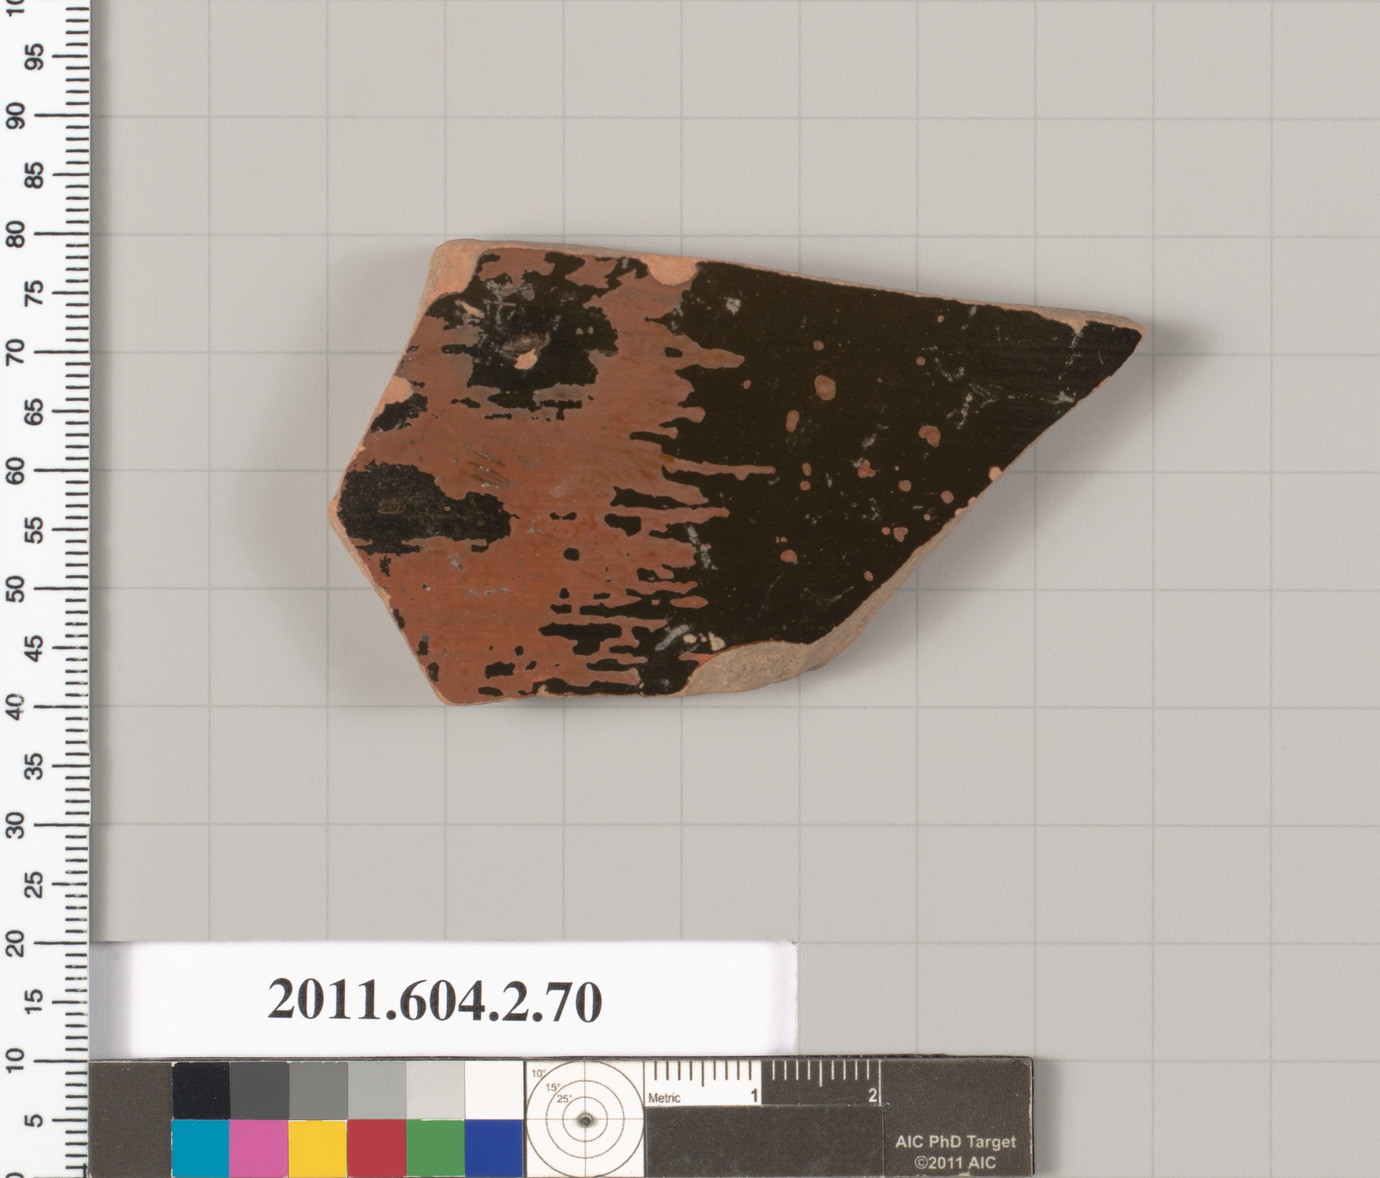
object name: amphora fragment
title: Terracotta fragment of an amphora (jar)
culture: greek, attic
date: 534-468 BCE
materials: terracotta